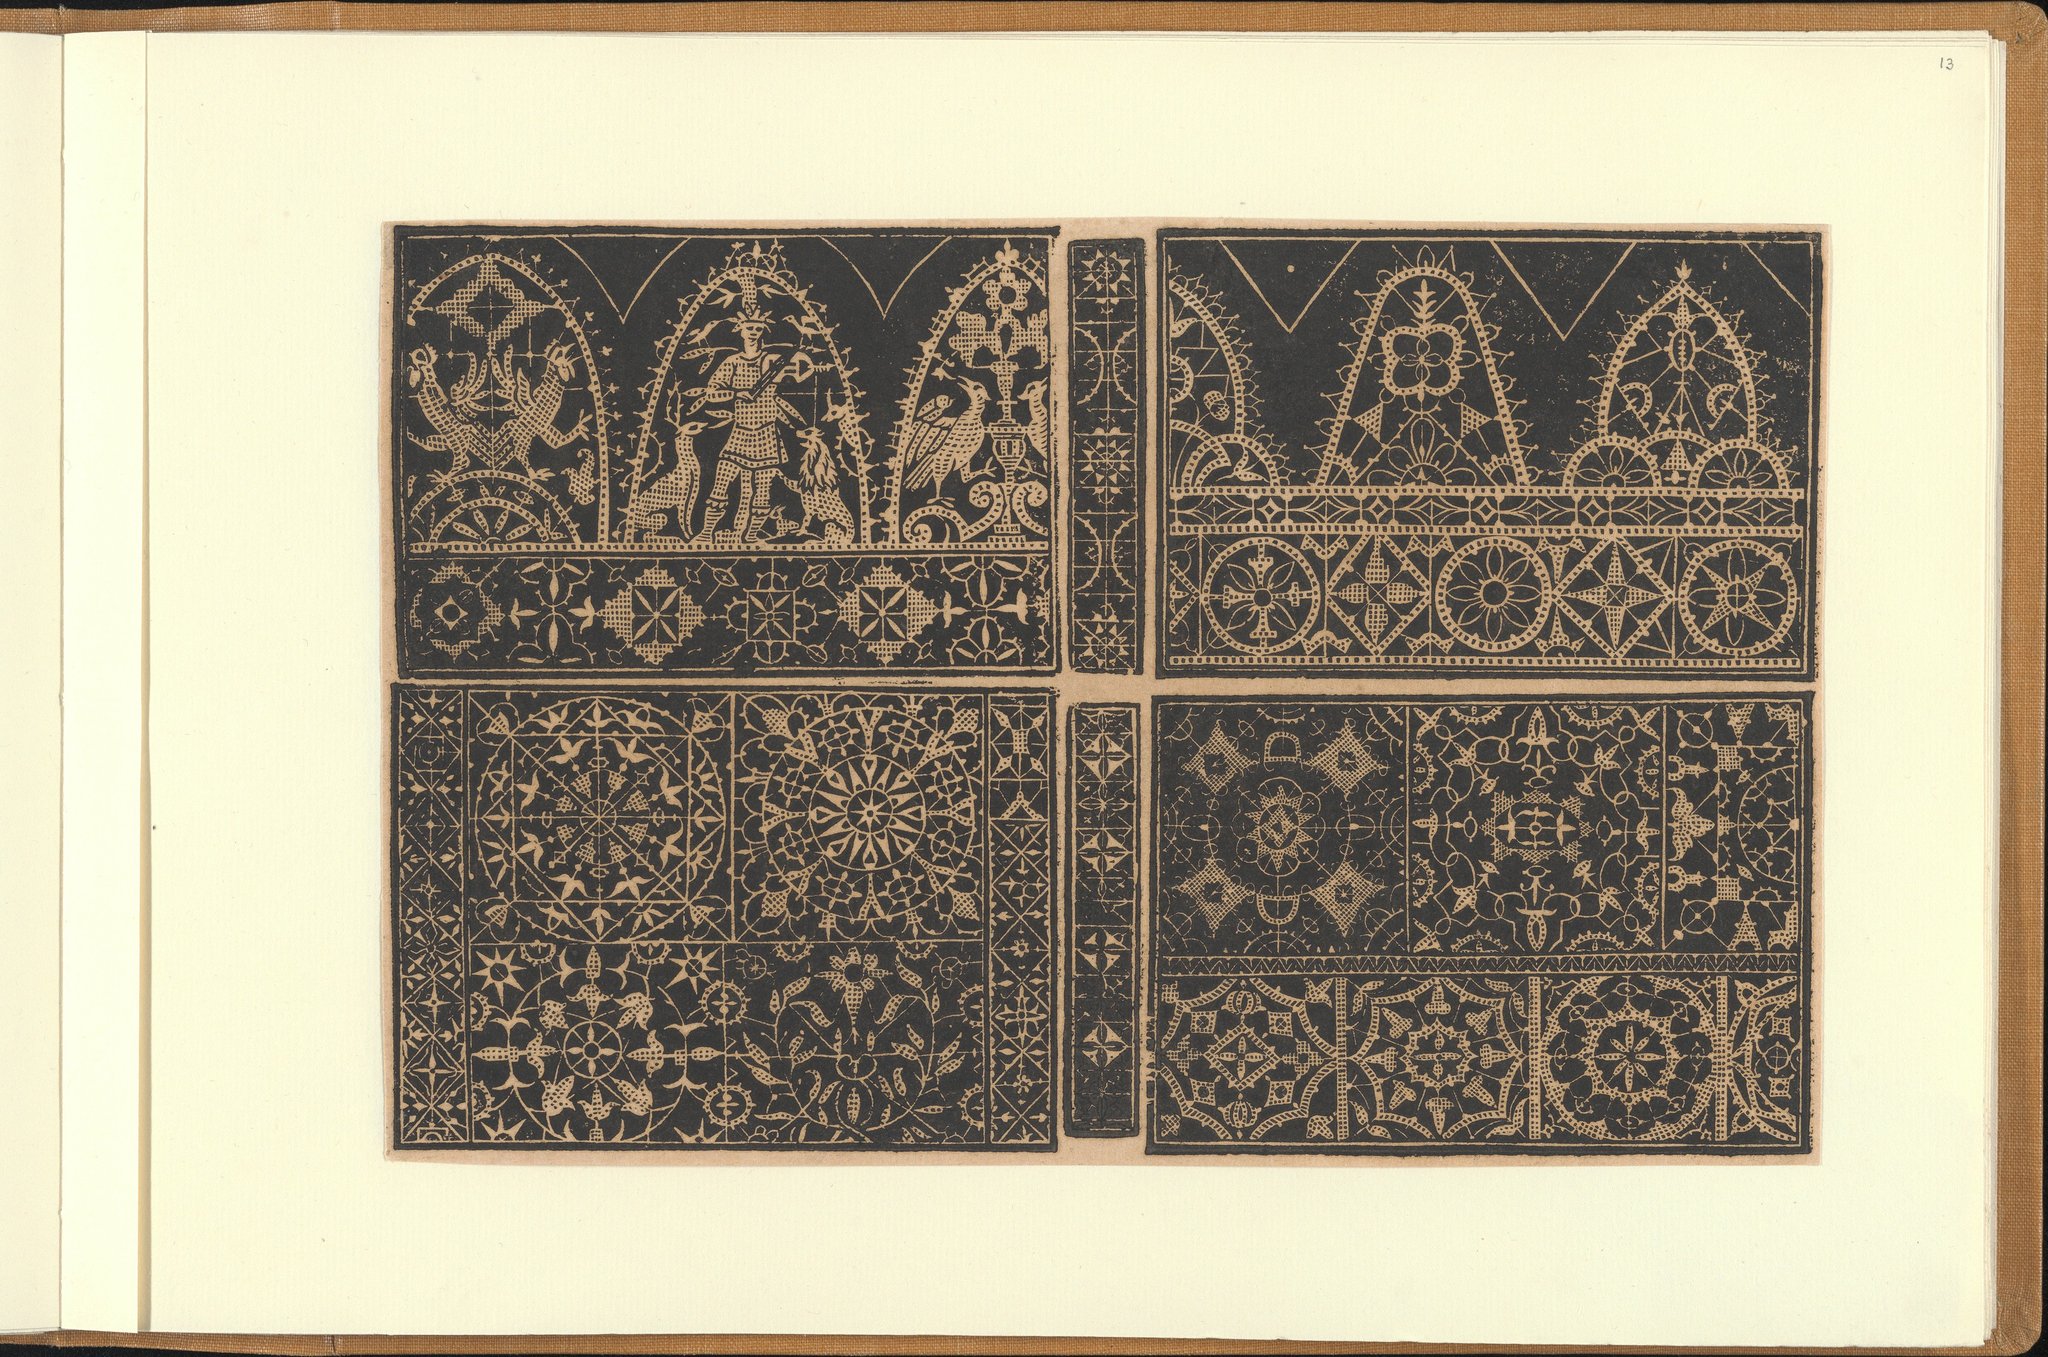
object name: album print ornament architecture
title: Schon newes Modelbuch...Page 13(r)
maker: sigismundus latomus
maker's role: designer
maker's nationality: german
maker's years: 1599-1632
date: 1617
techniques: woodcut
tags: animals,birds,ornament